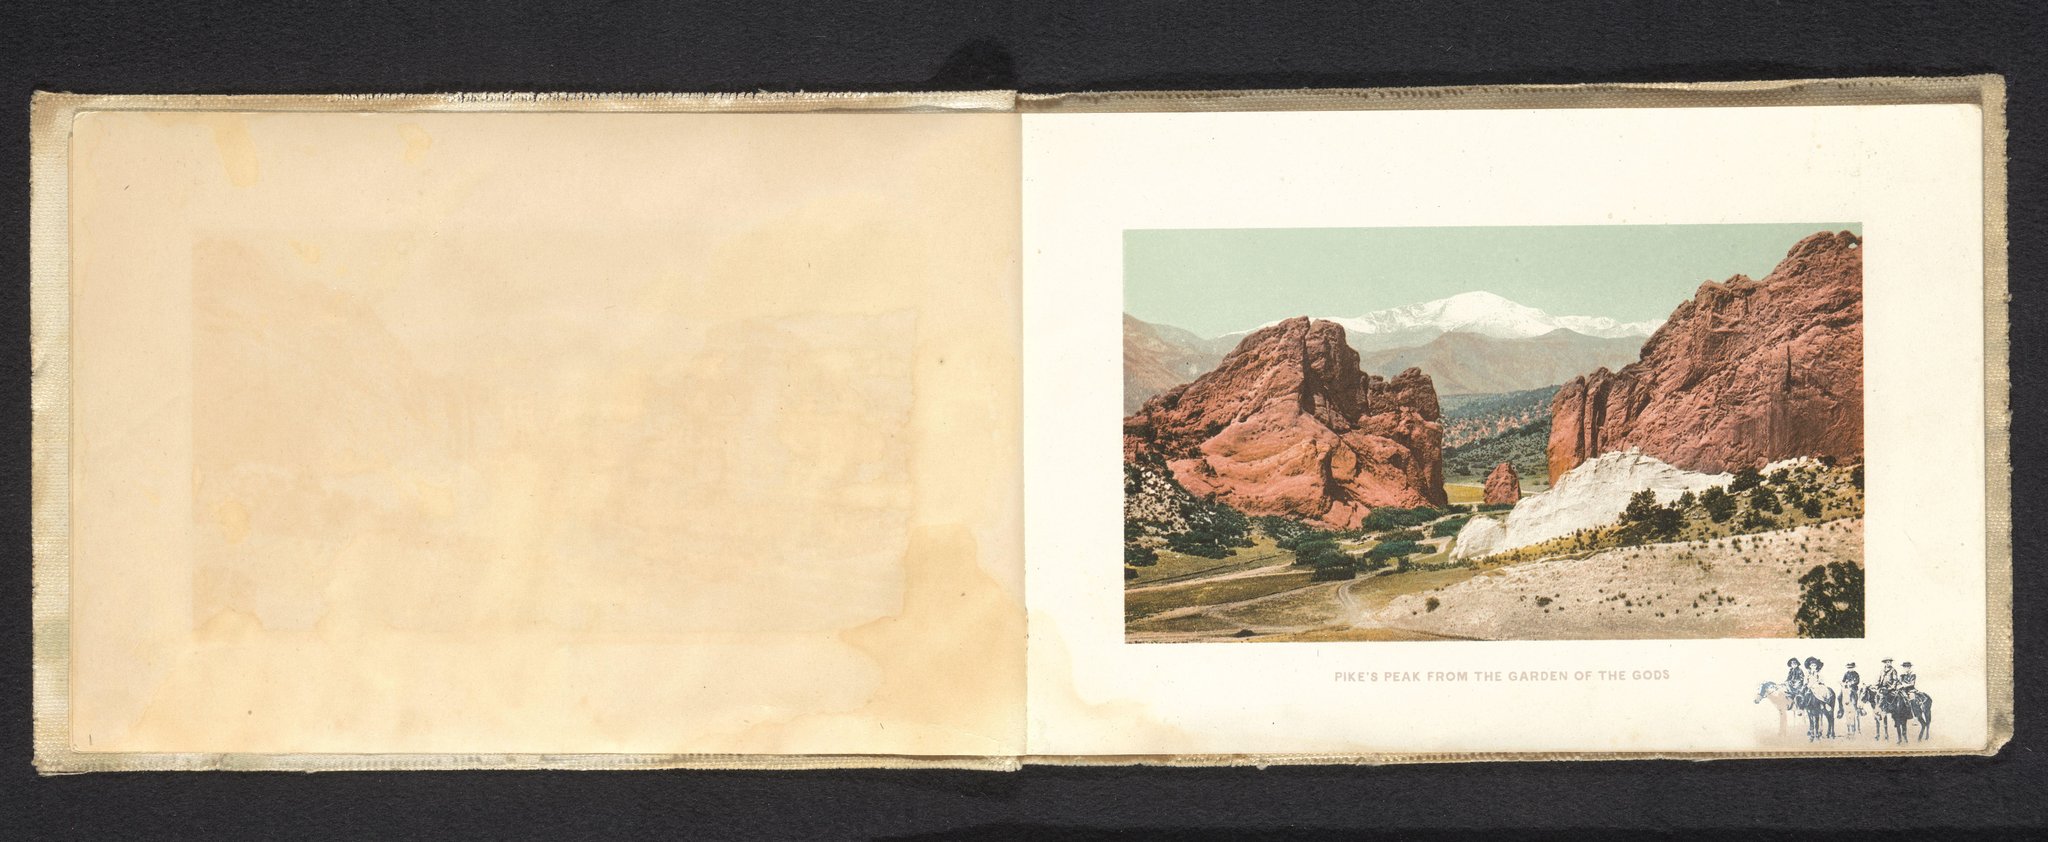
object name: photomechanical print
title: Gezicht op Pike's Peak en de Tuin der goden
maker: Anonymous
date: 1894-1899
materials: paper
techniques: lithograph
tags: mountains